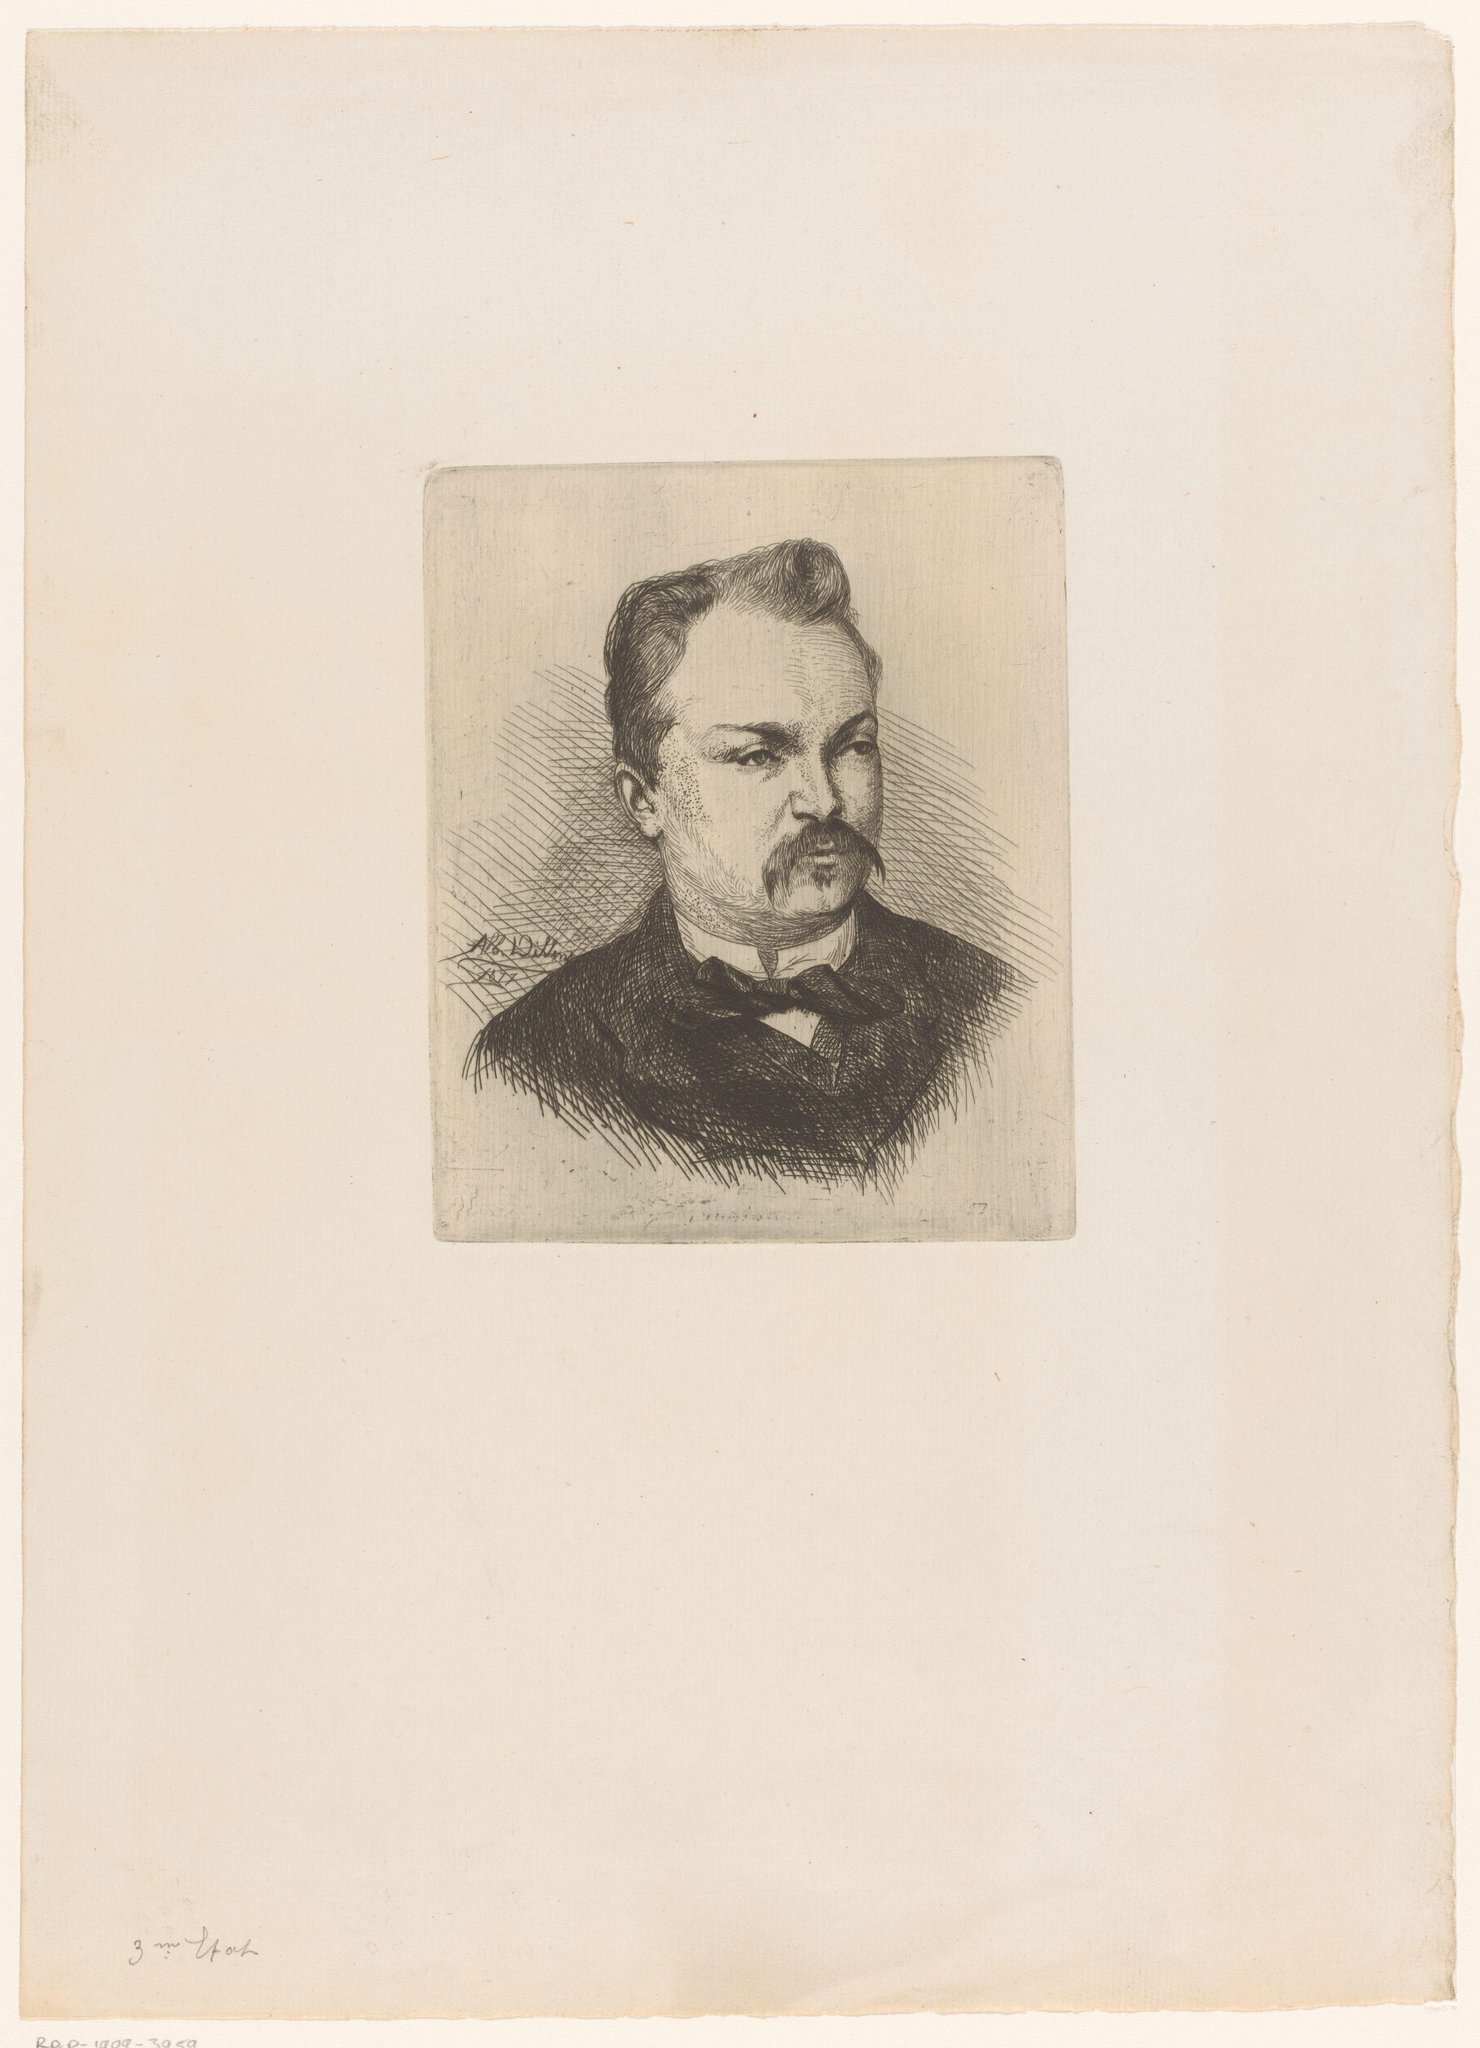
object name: print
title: Portret van een onbekende man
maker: albert dillens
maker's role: print maker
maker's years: 1844-1915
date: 1877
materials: paper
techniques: etching, intaglio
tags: adult man, historical persons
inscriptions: inscription: ‘Portrait de [6] Janson’, collector's mark: Lugt 2228, inscription: ‘3m Etat’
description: Mogelijk gaat het om een kamerlid genaamd Janson.